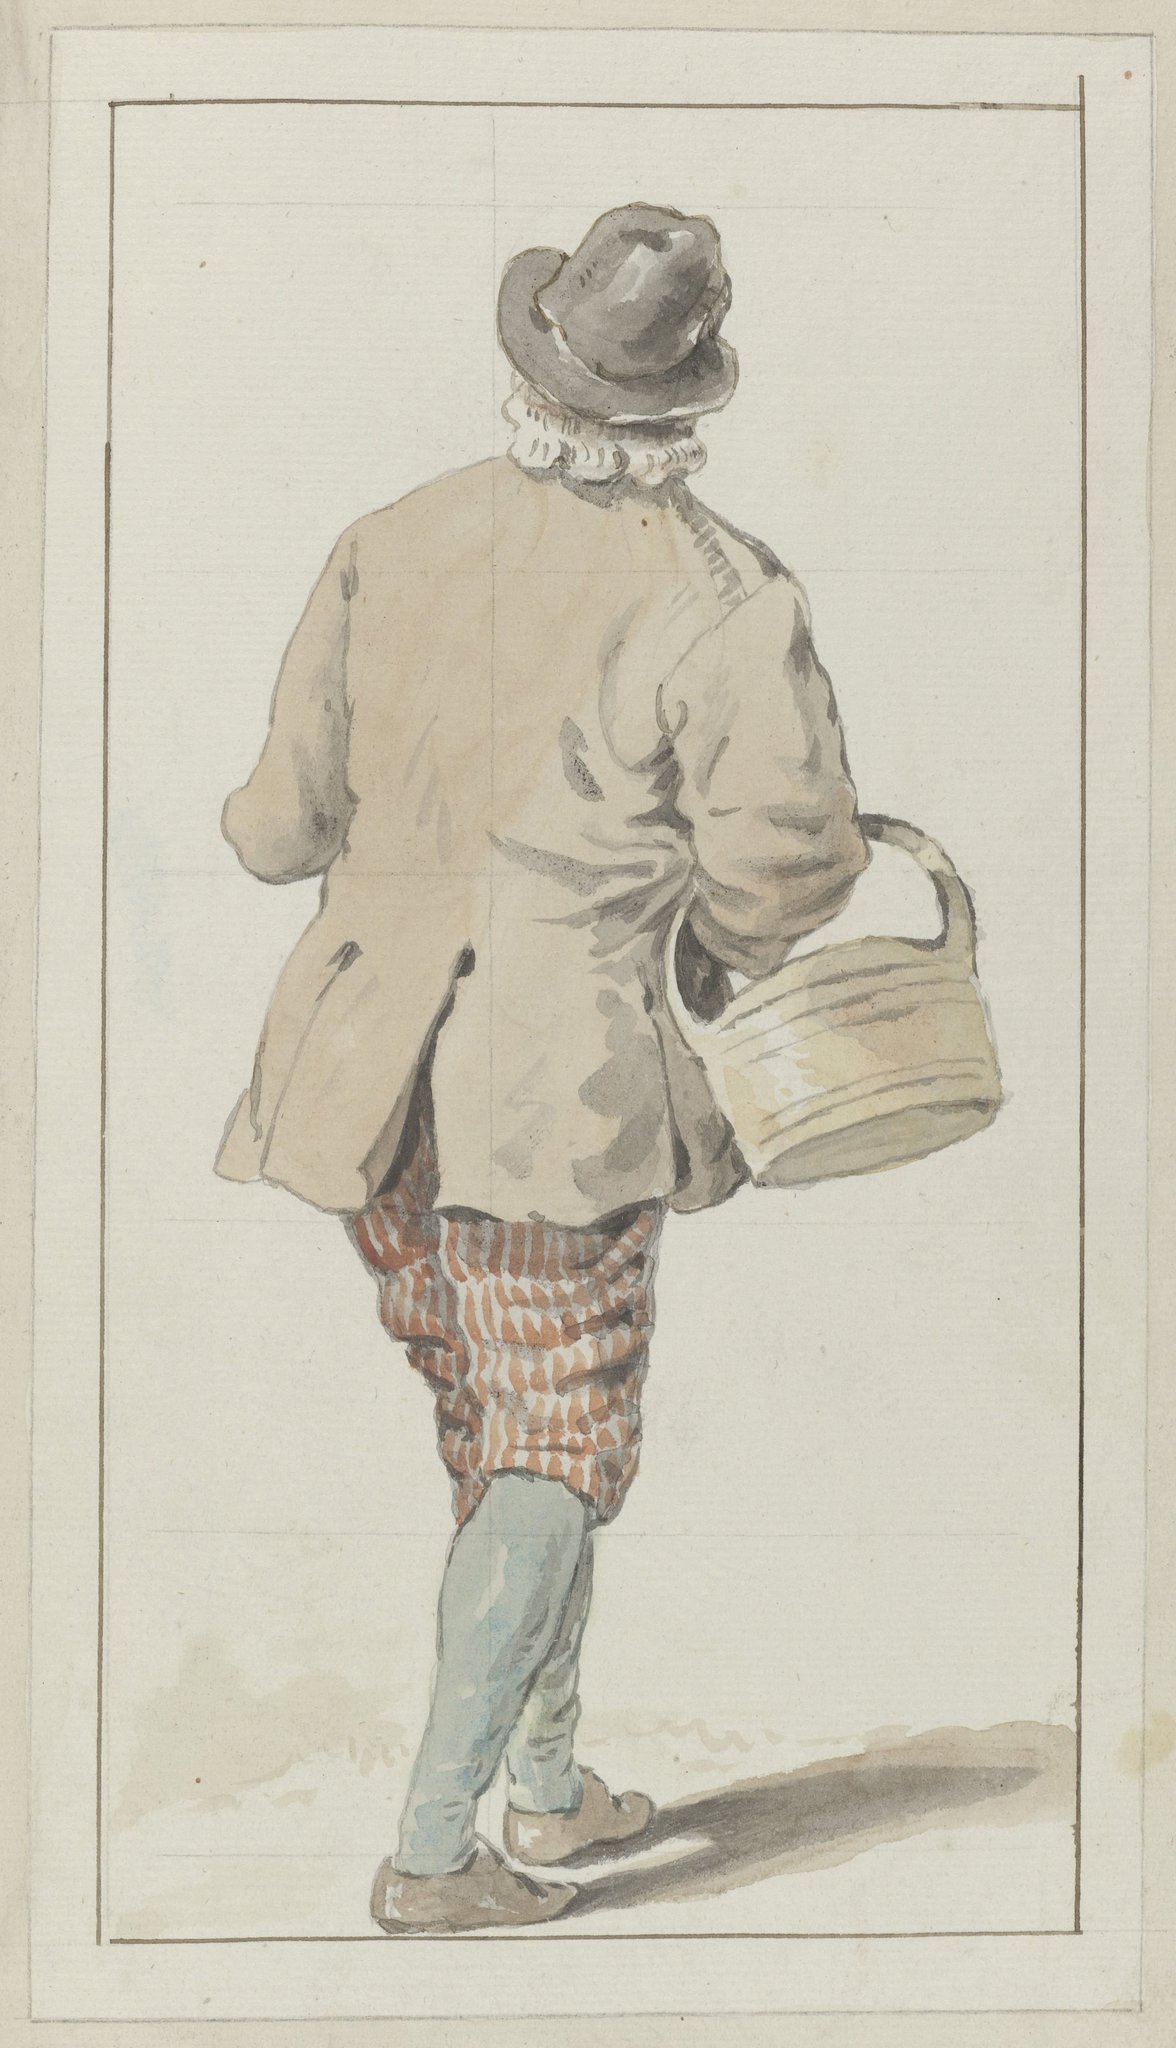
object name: drawing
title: Man met hoed en mand op de rug gezien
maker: Anonymous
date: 1700-1799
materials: paper, watercolor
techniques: brush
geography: netherlands